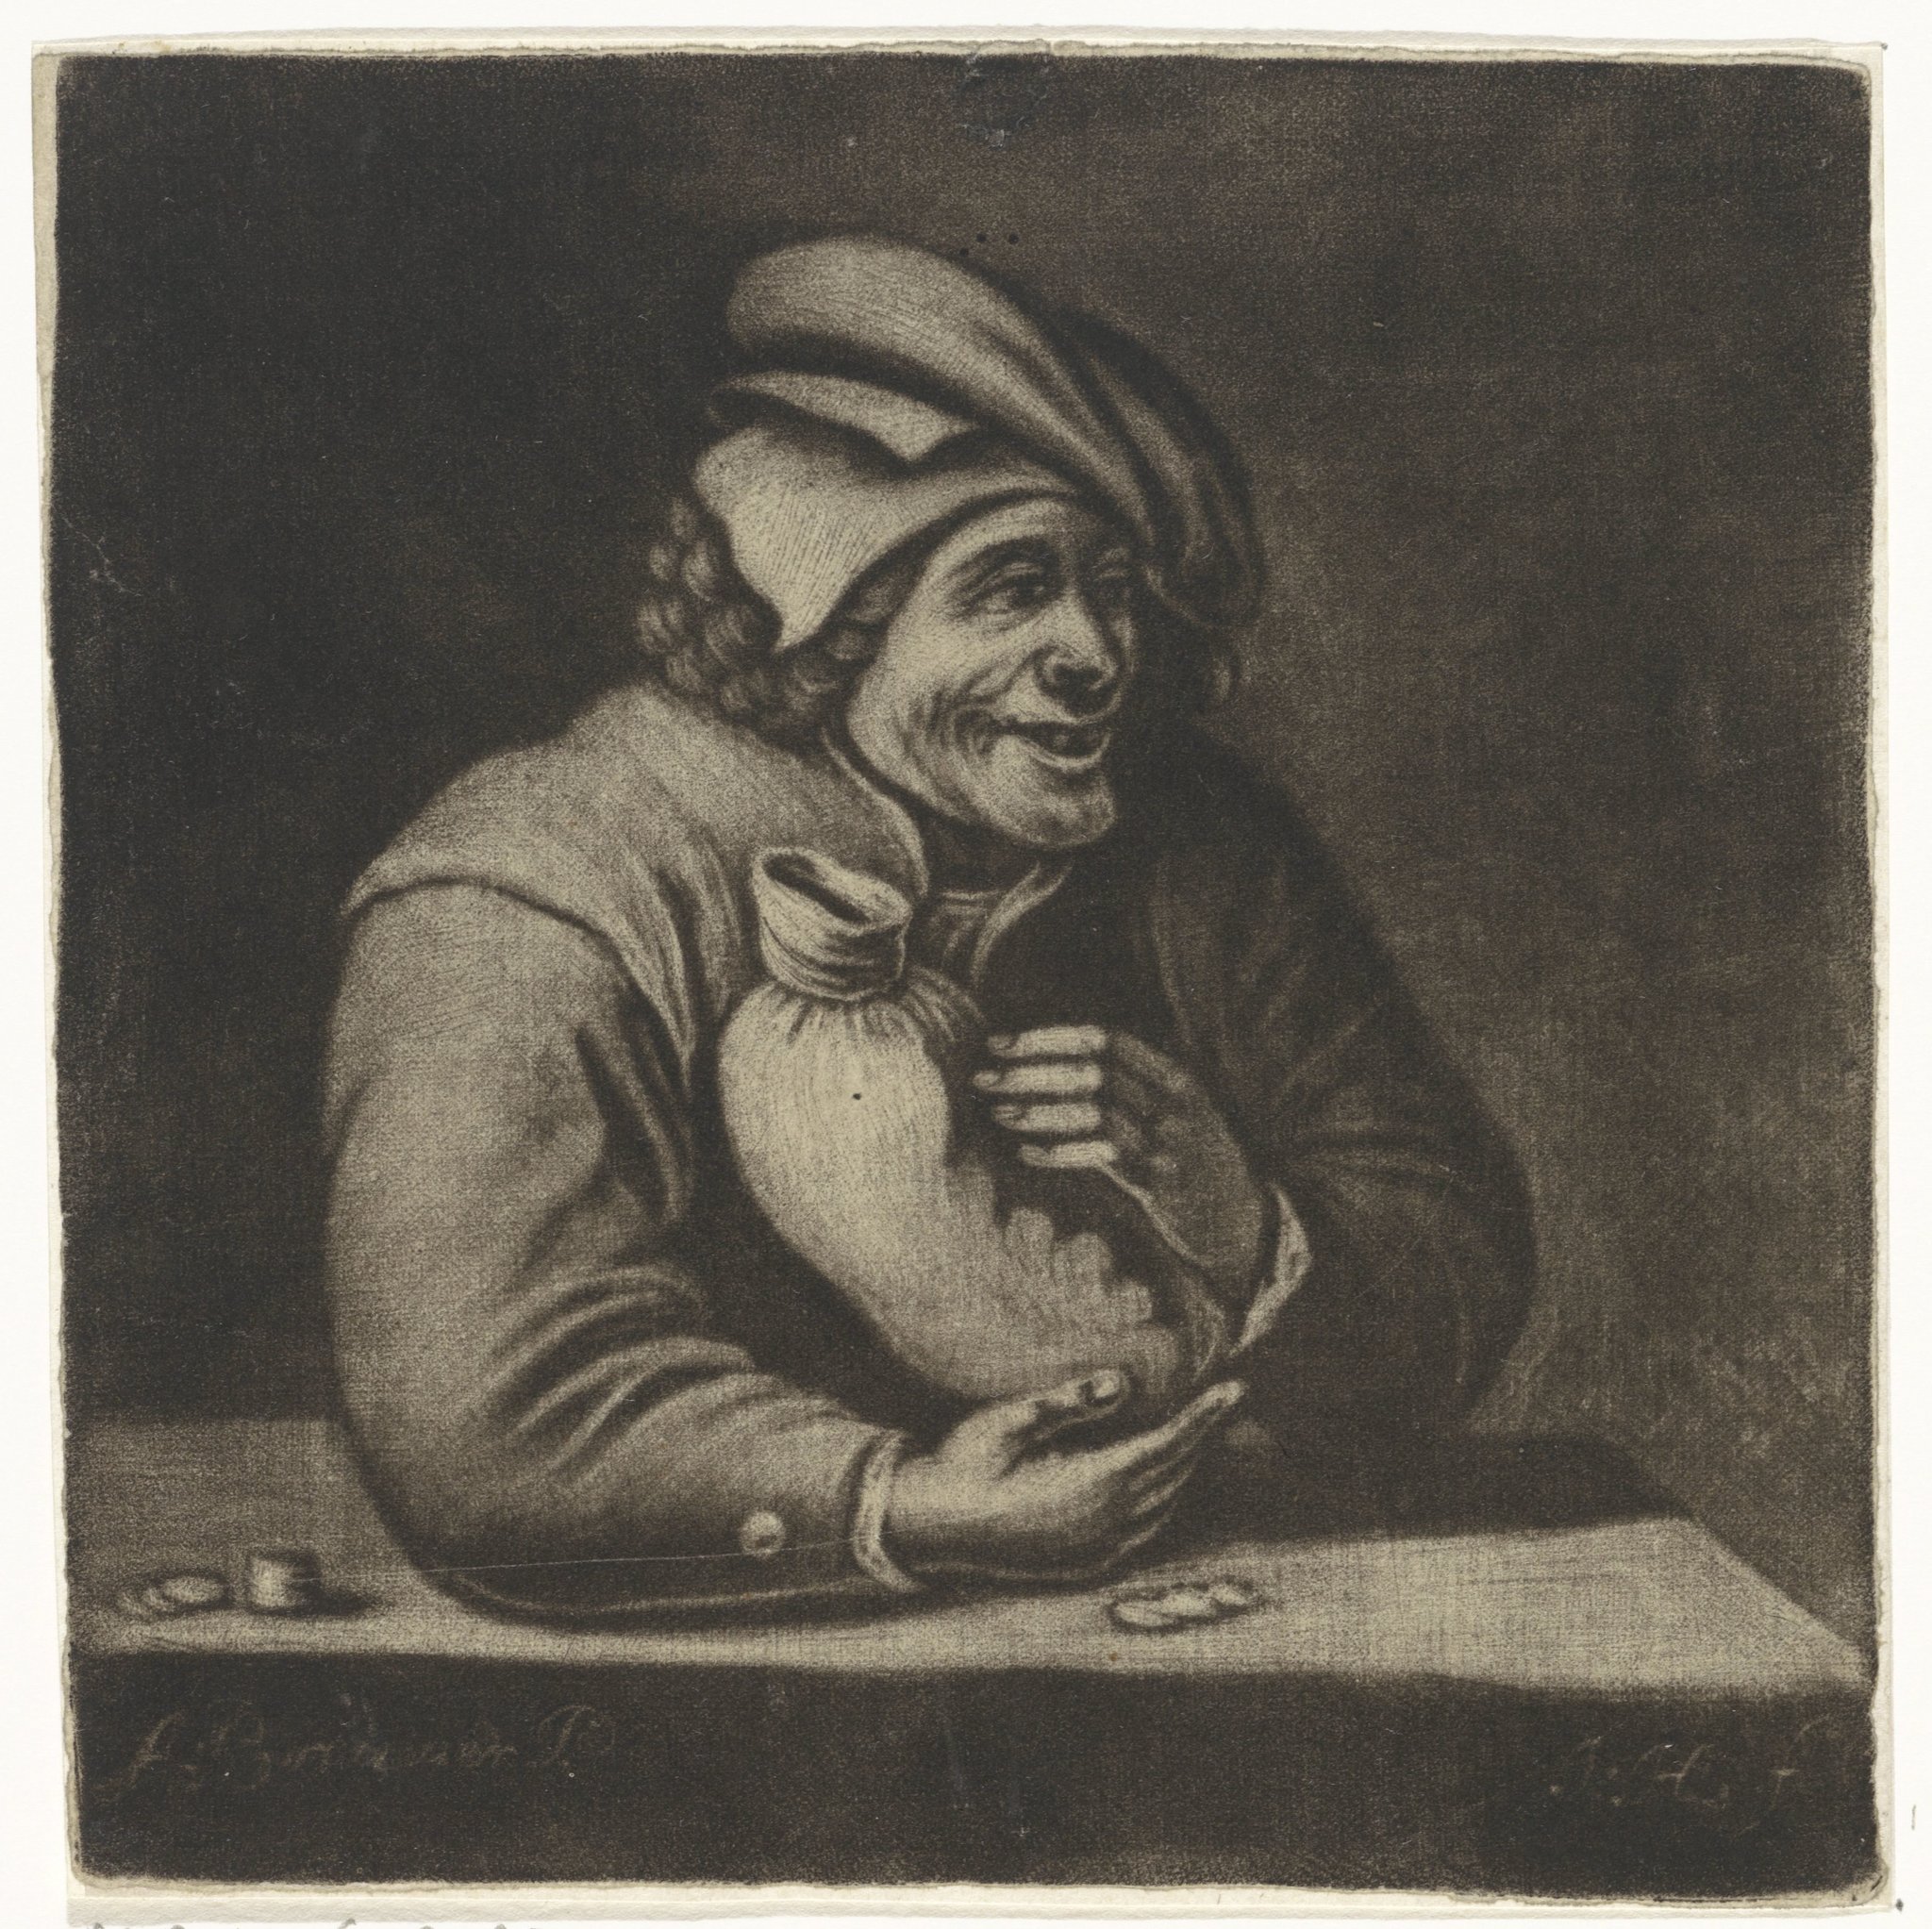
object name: print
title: Man met een geldzak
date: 1723-1789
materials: paper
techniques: mezzotint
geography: dordrecht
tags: purse, money-bag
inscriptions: collector's mark: Lugt 2228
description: Een zittende man omarmt een geldzak. Hij draagt een muts.